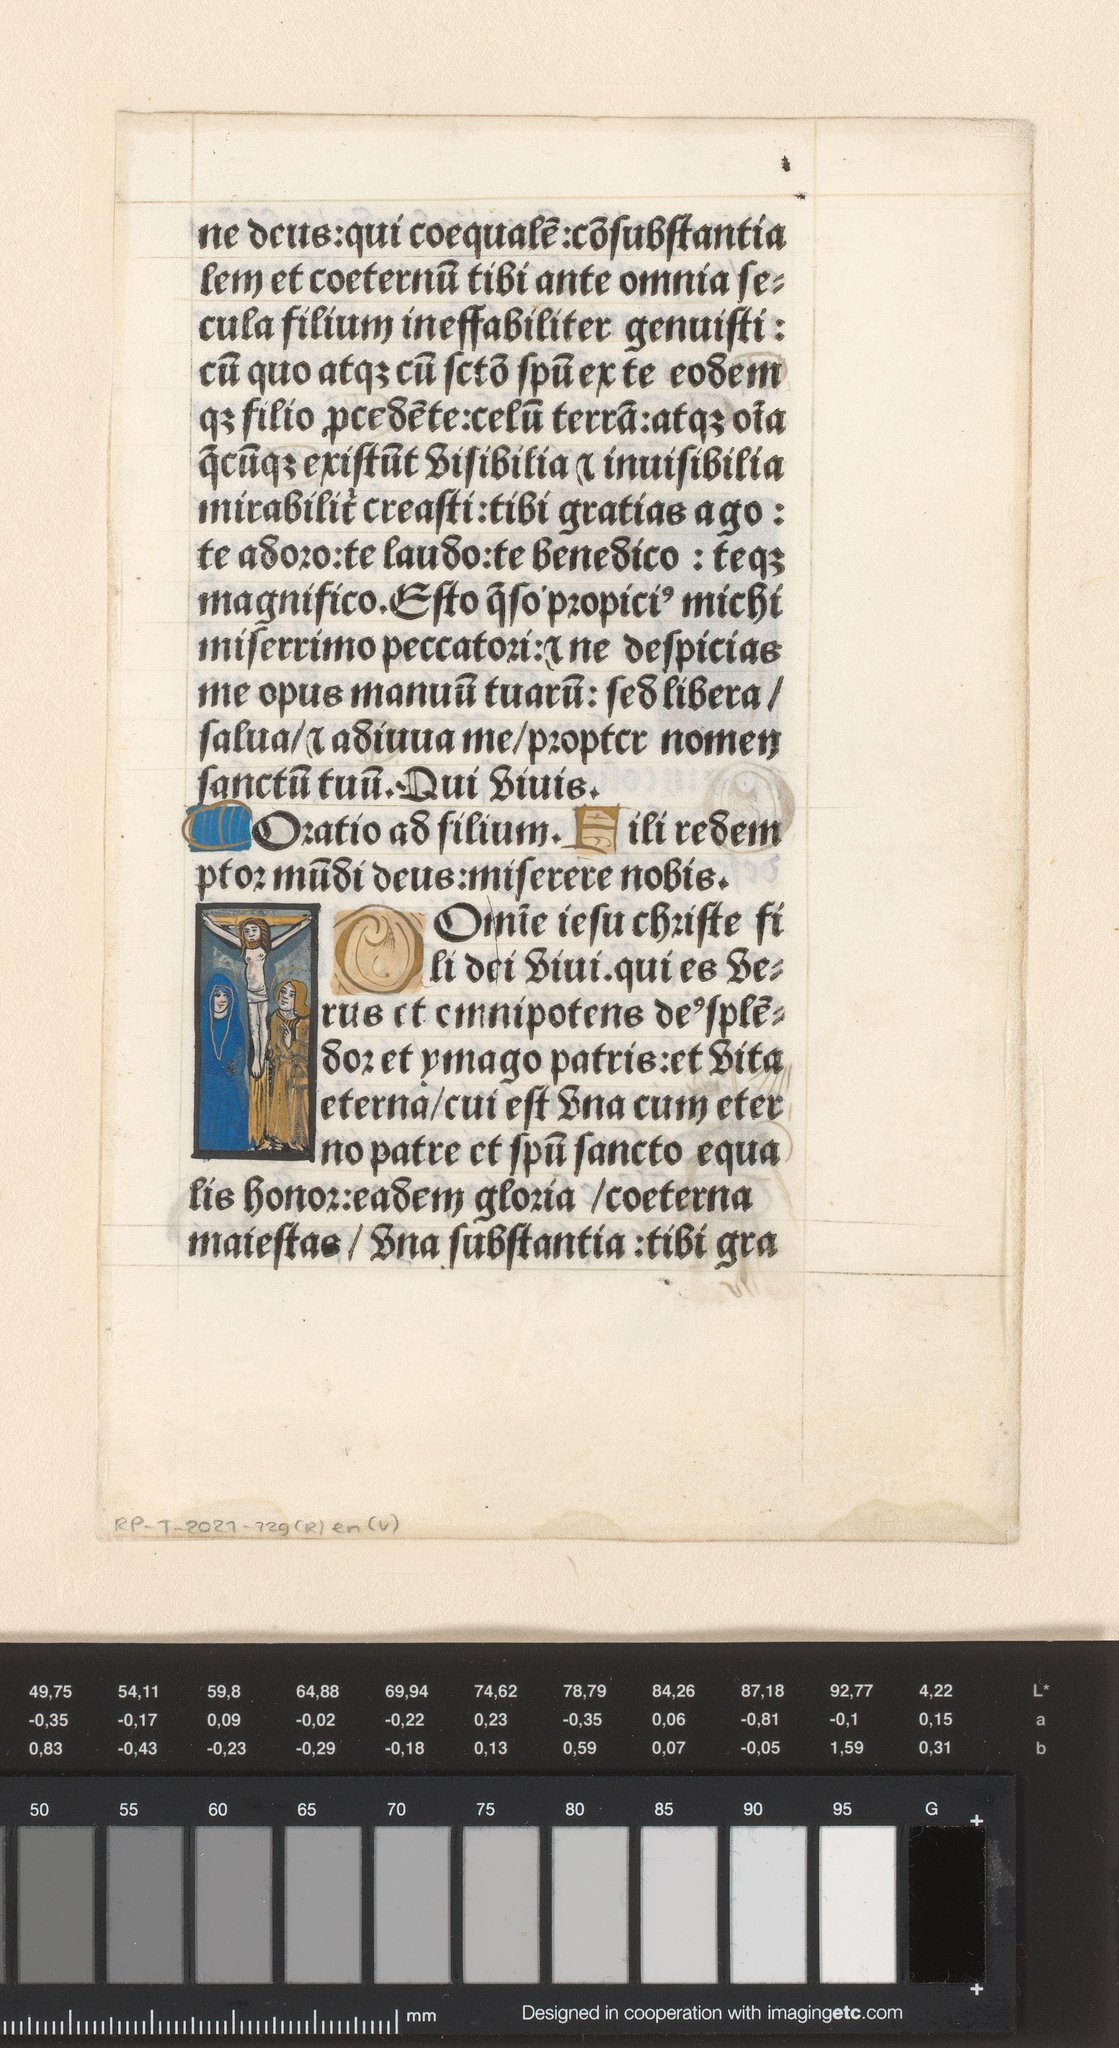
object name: manuscript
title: Blad met handschrift en Christus aan het kruis, mogelijk uit een getijdenboek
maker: Anonymous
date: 1500-1599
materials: paint, ink, parchment, watercolor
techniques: brush, pen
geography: france